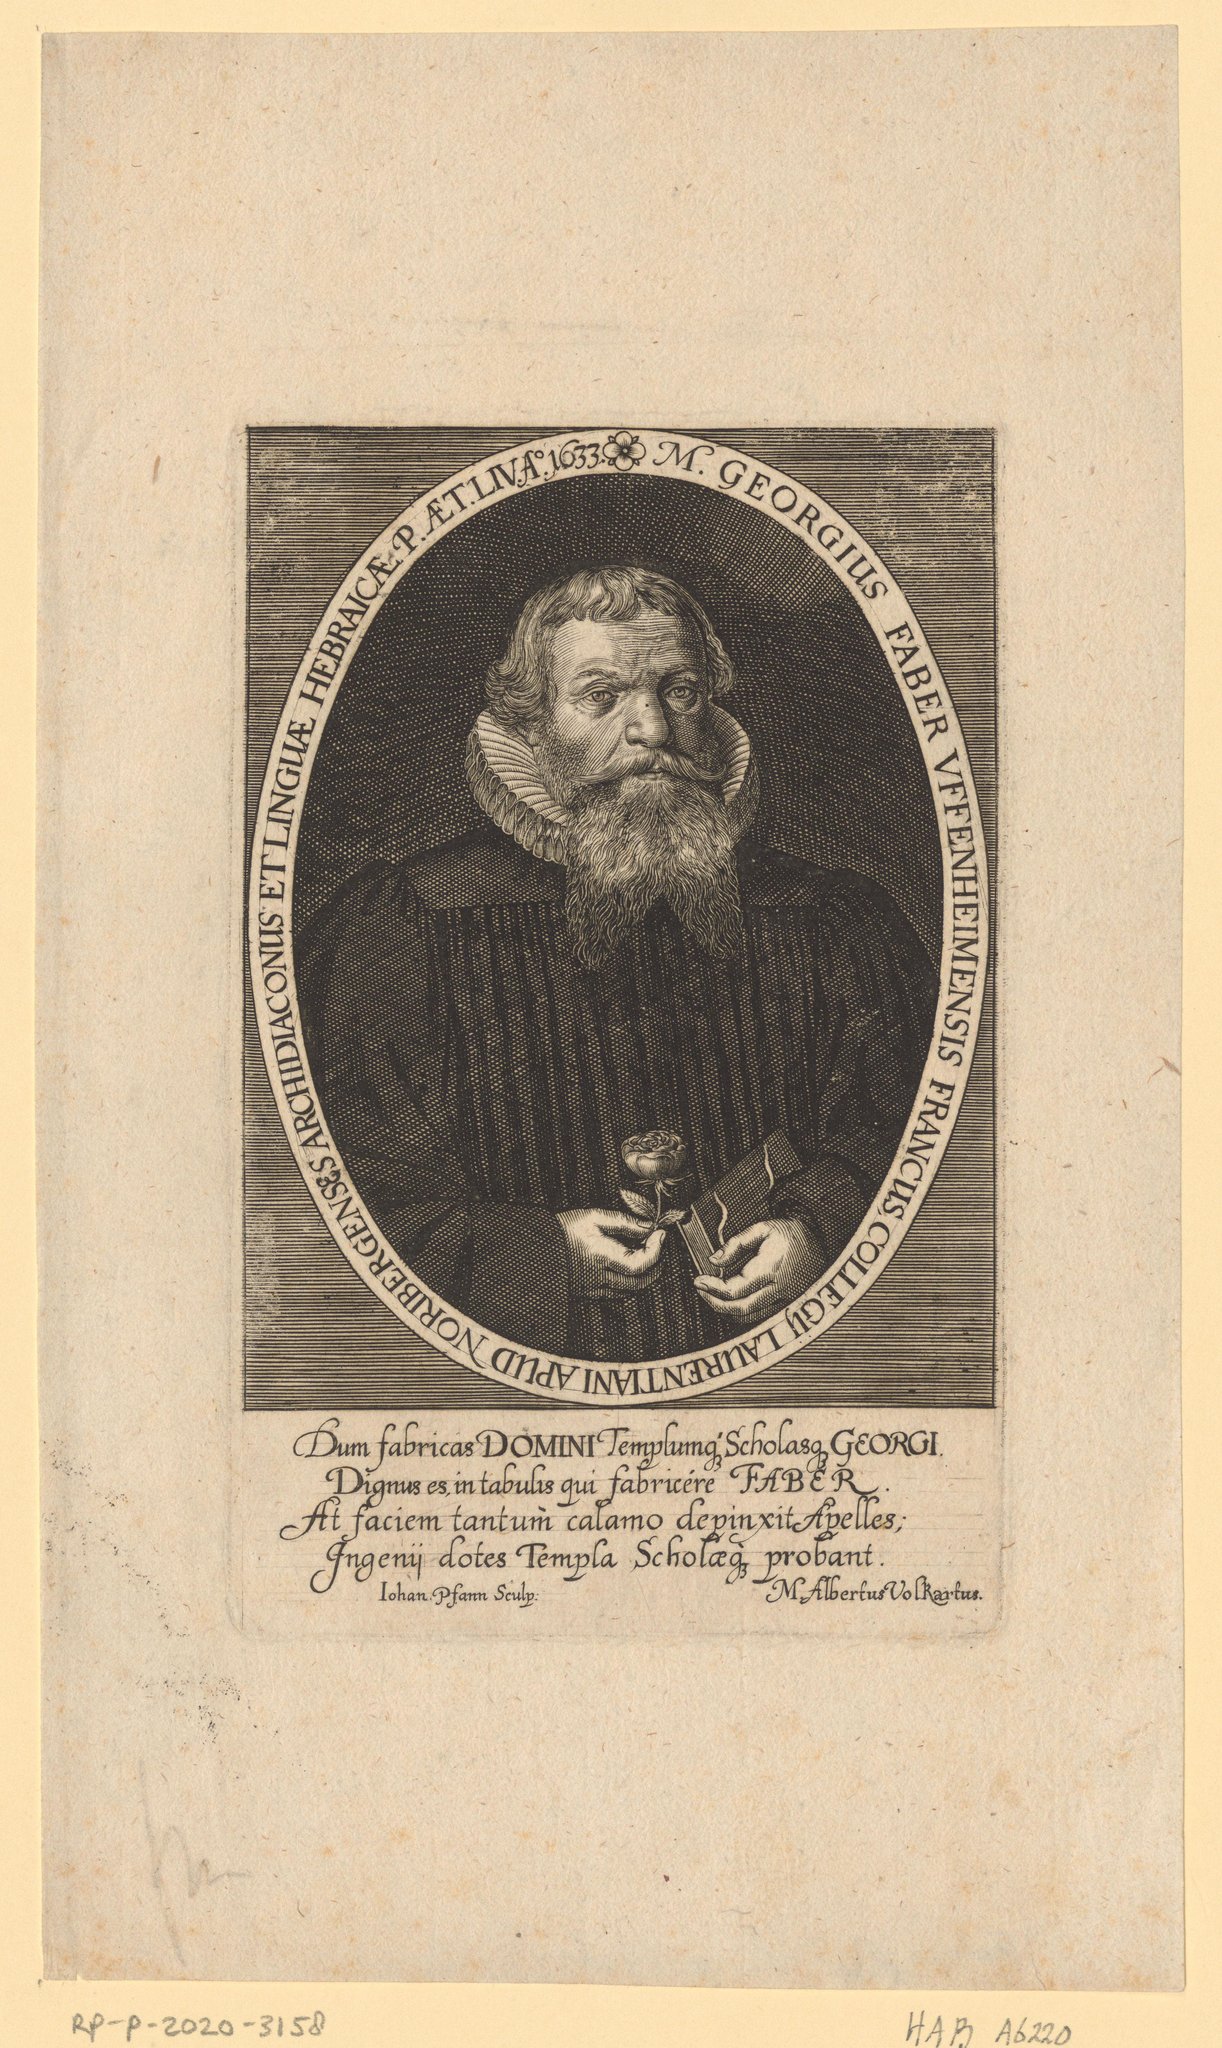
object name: print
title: Portret van Georg Faber op 54-jarige leeftijd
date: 1648-1663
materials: paper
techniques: engraving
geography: nuremberg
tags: historical persons, book, flowers: rose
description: Met vierregelig vers in het Latijn onder het portret.